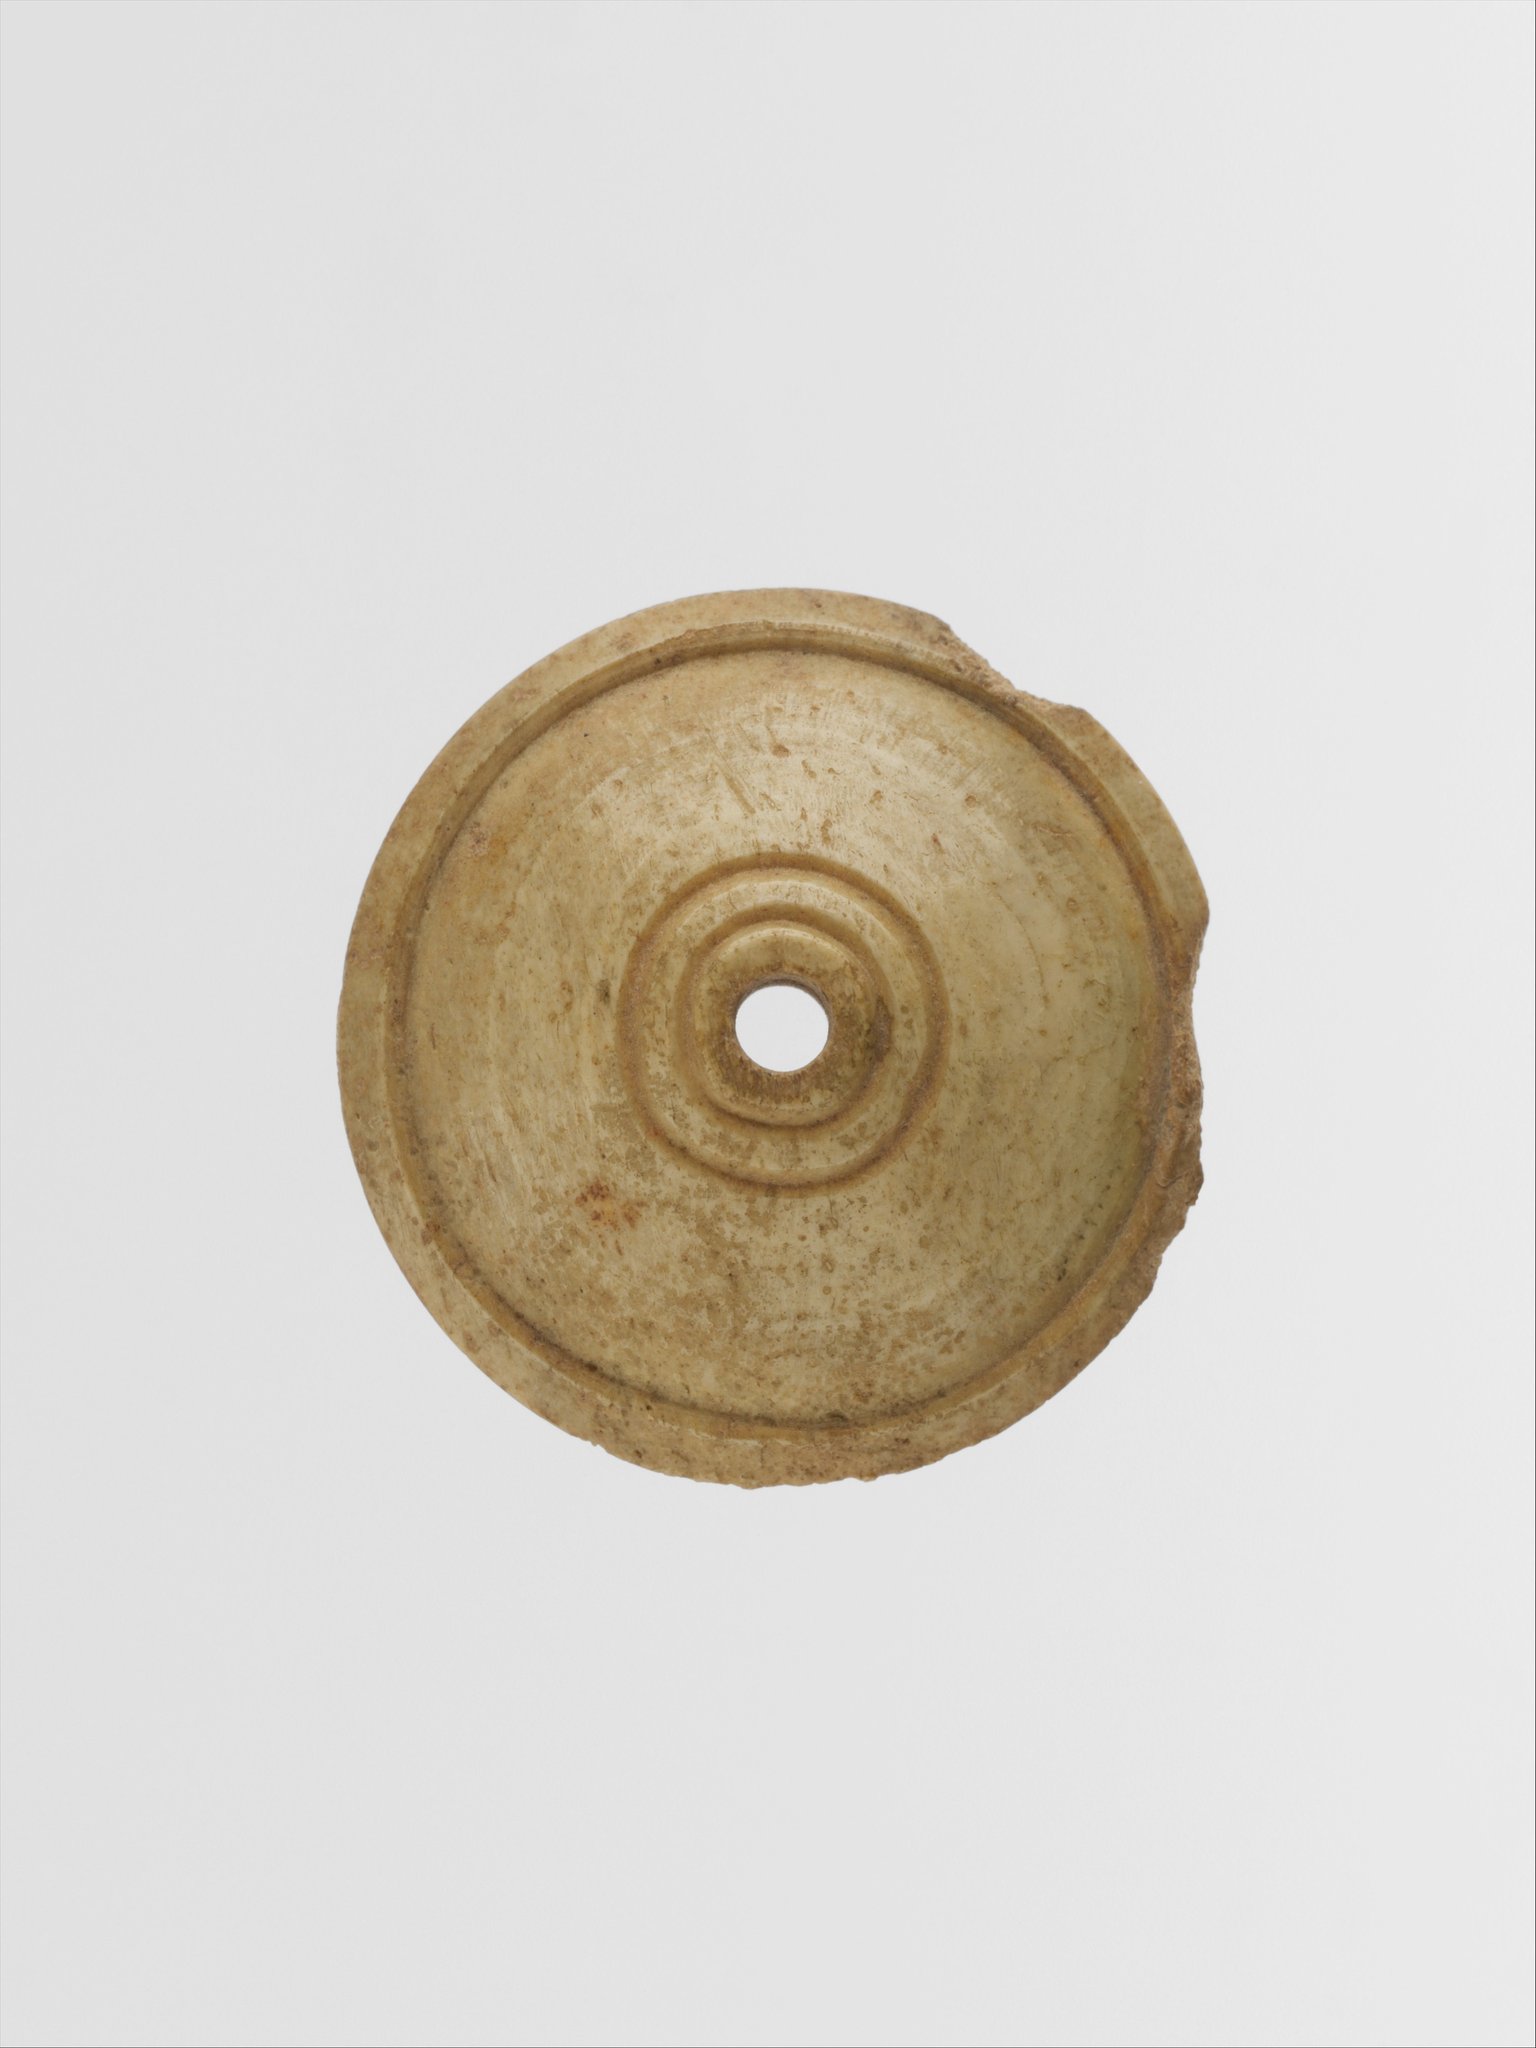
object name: disk or button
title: Bone disk or button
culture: roman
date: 1-100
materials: bone, ivory